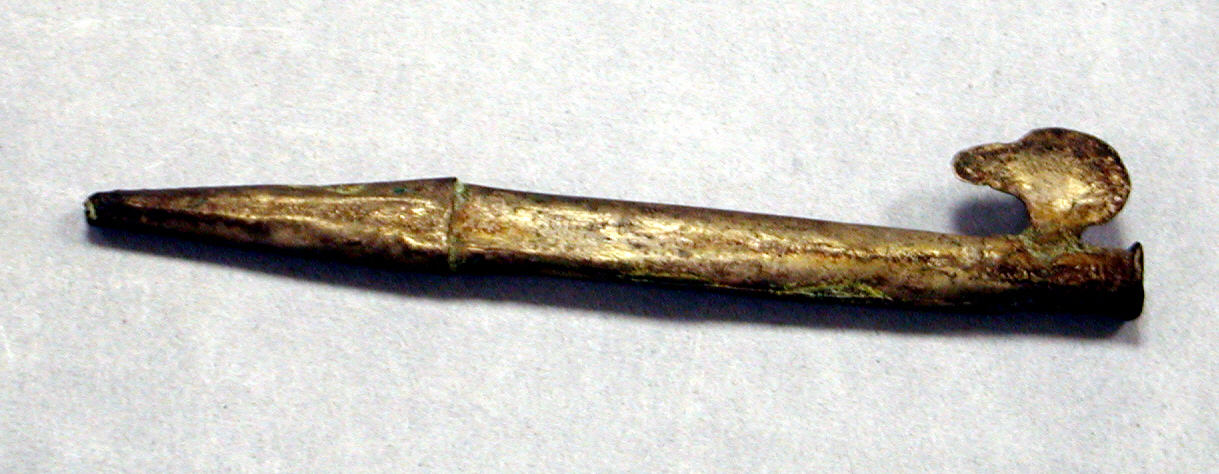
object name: spear thrower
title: Miniature Spear Thrower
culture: peruvian, north or central coast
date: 701-1566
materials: gilt, silver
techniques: hammering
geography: peru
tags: spears